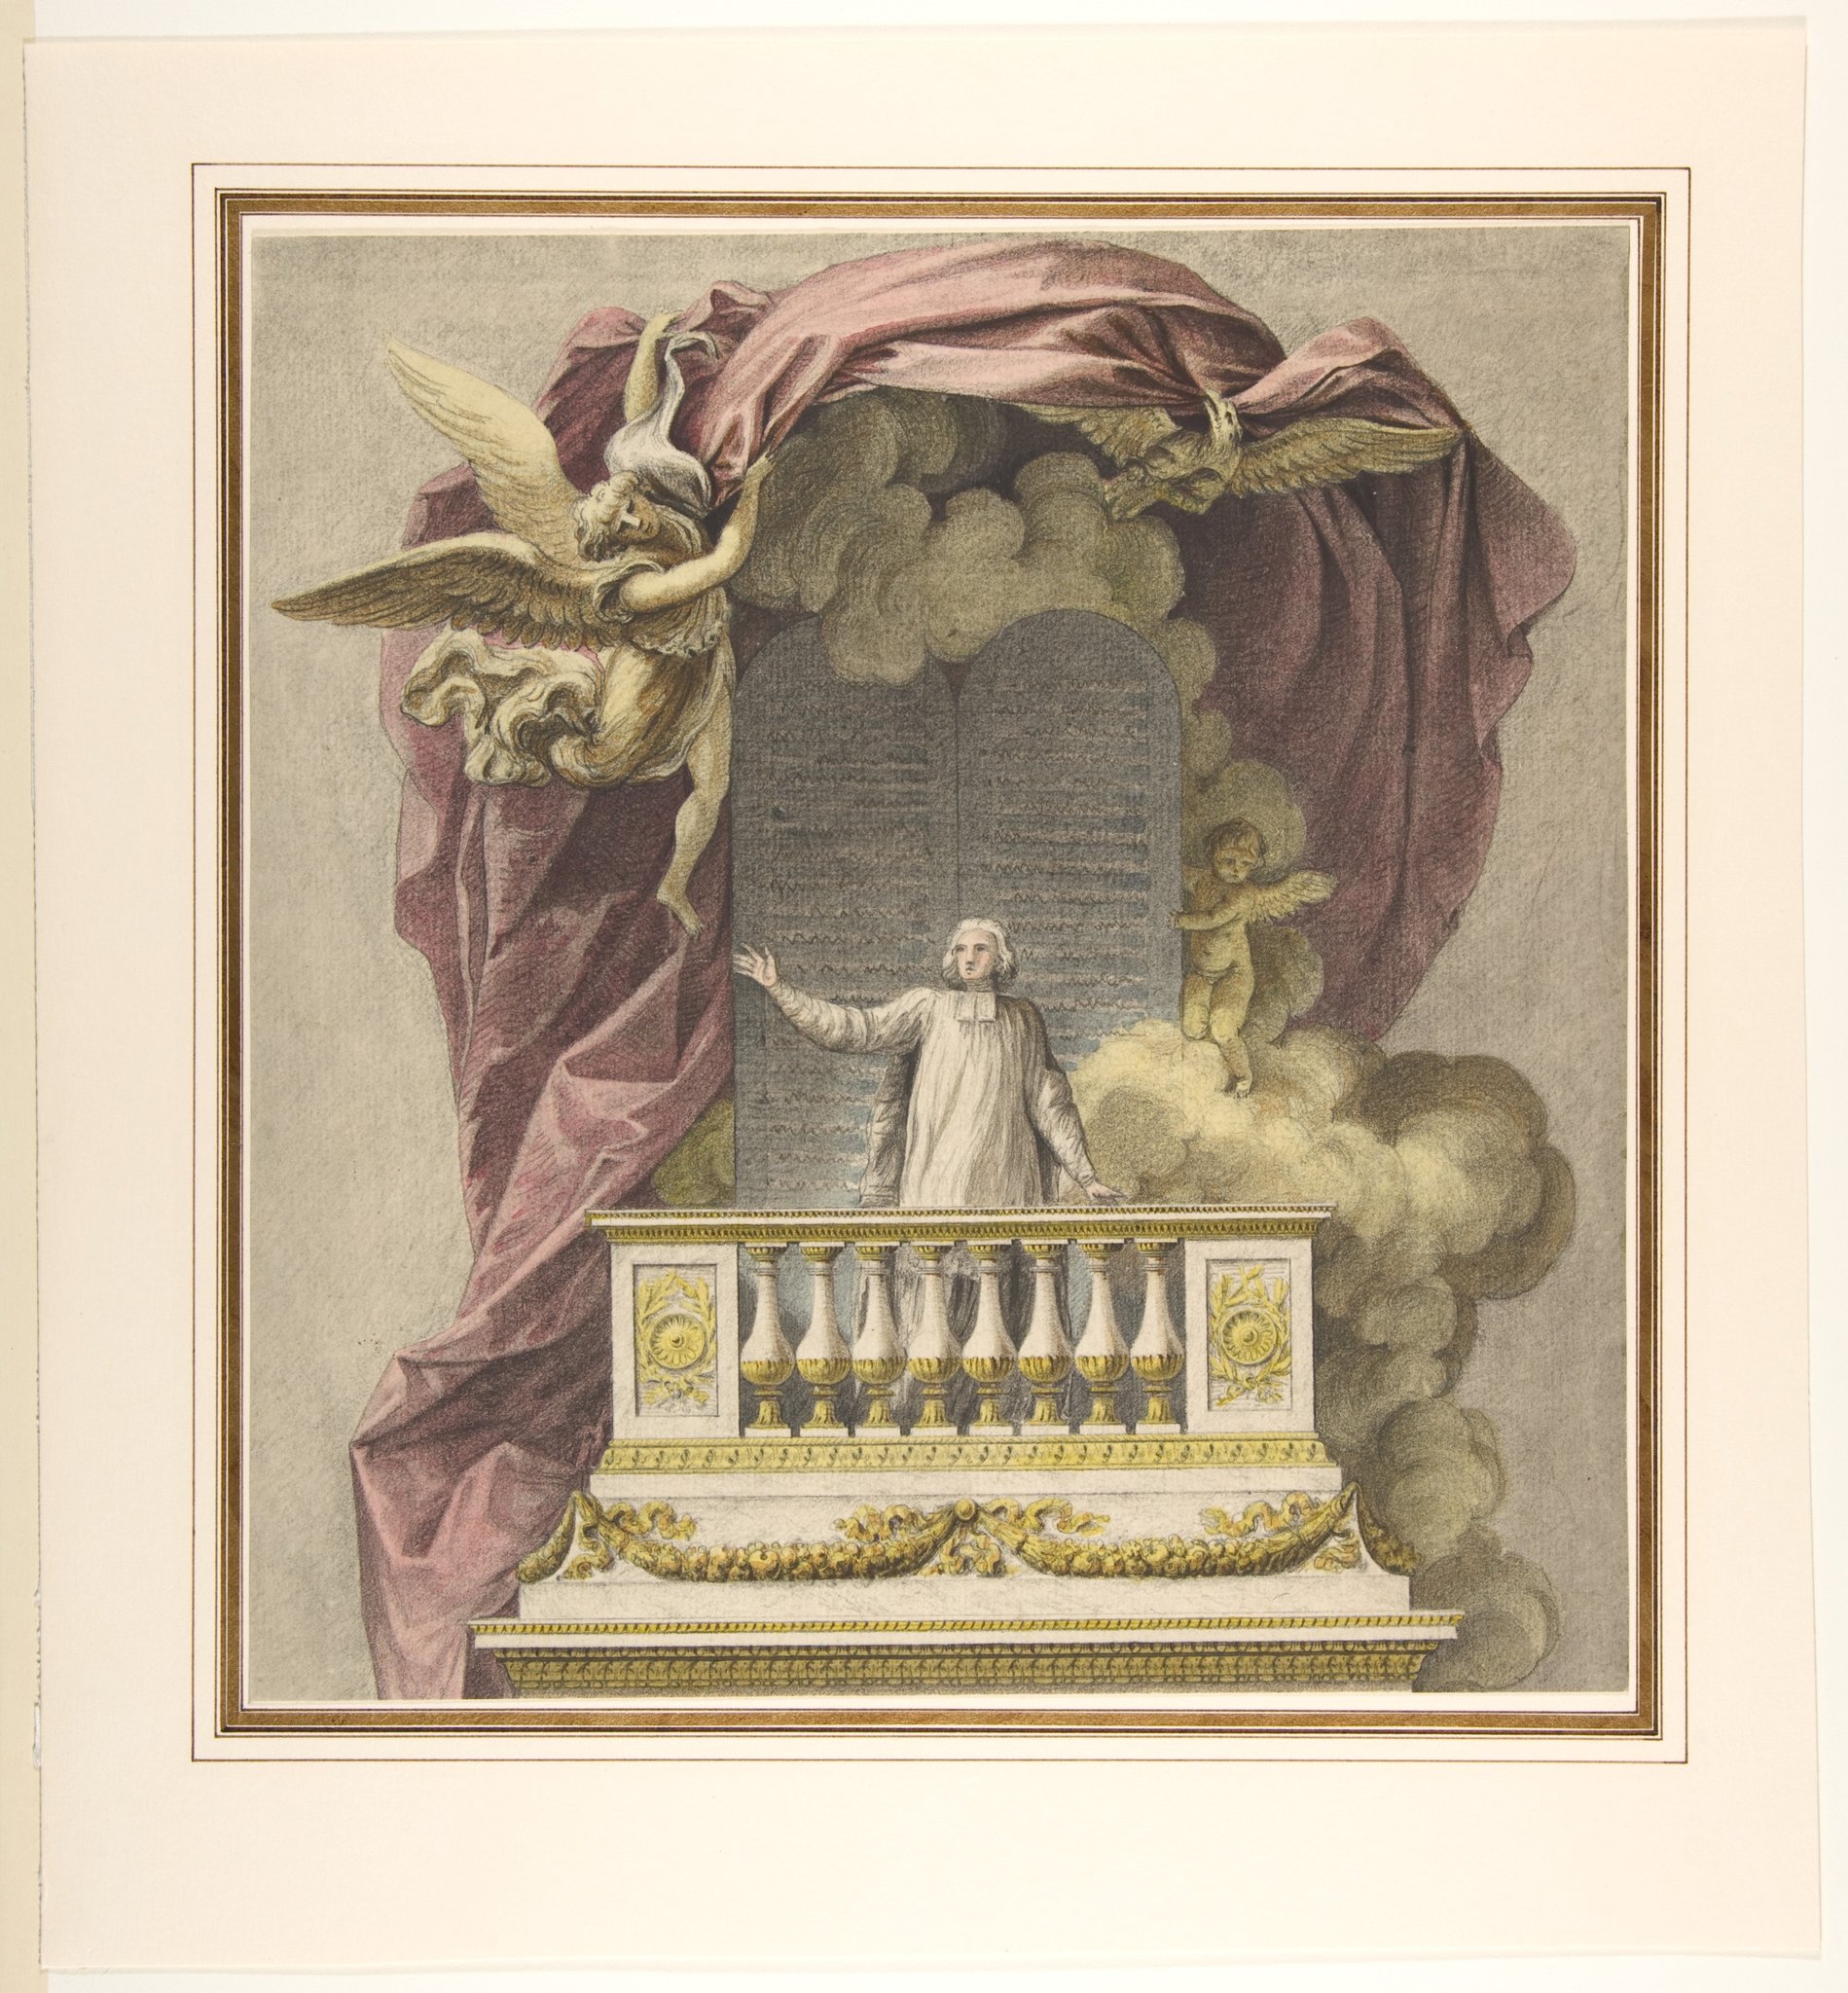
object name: drawing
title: Design for a Pulpit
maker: augustin pajou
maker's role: artist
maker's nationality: french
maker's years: 1730-1809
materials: chalk, graphite, ink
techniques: brush, pen, wash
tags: birds,men,angels